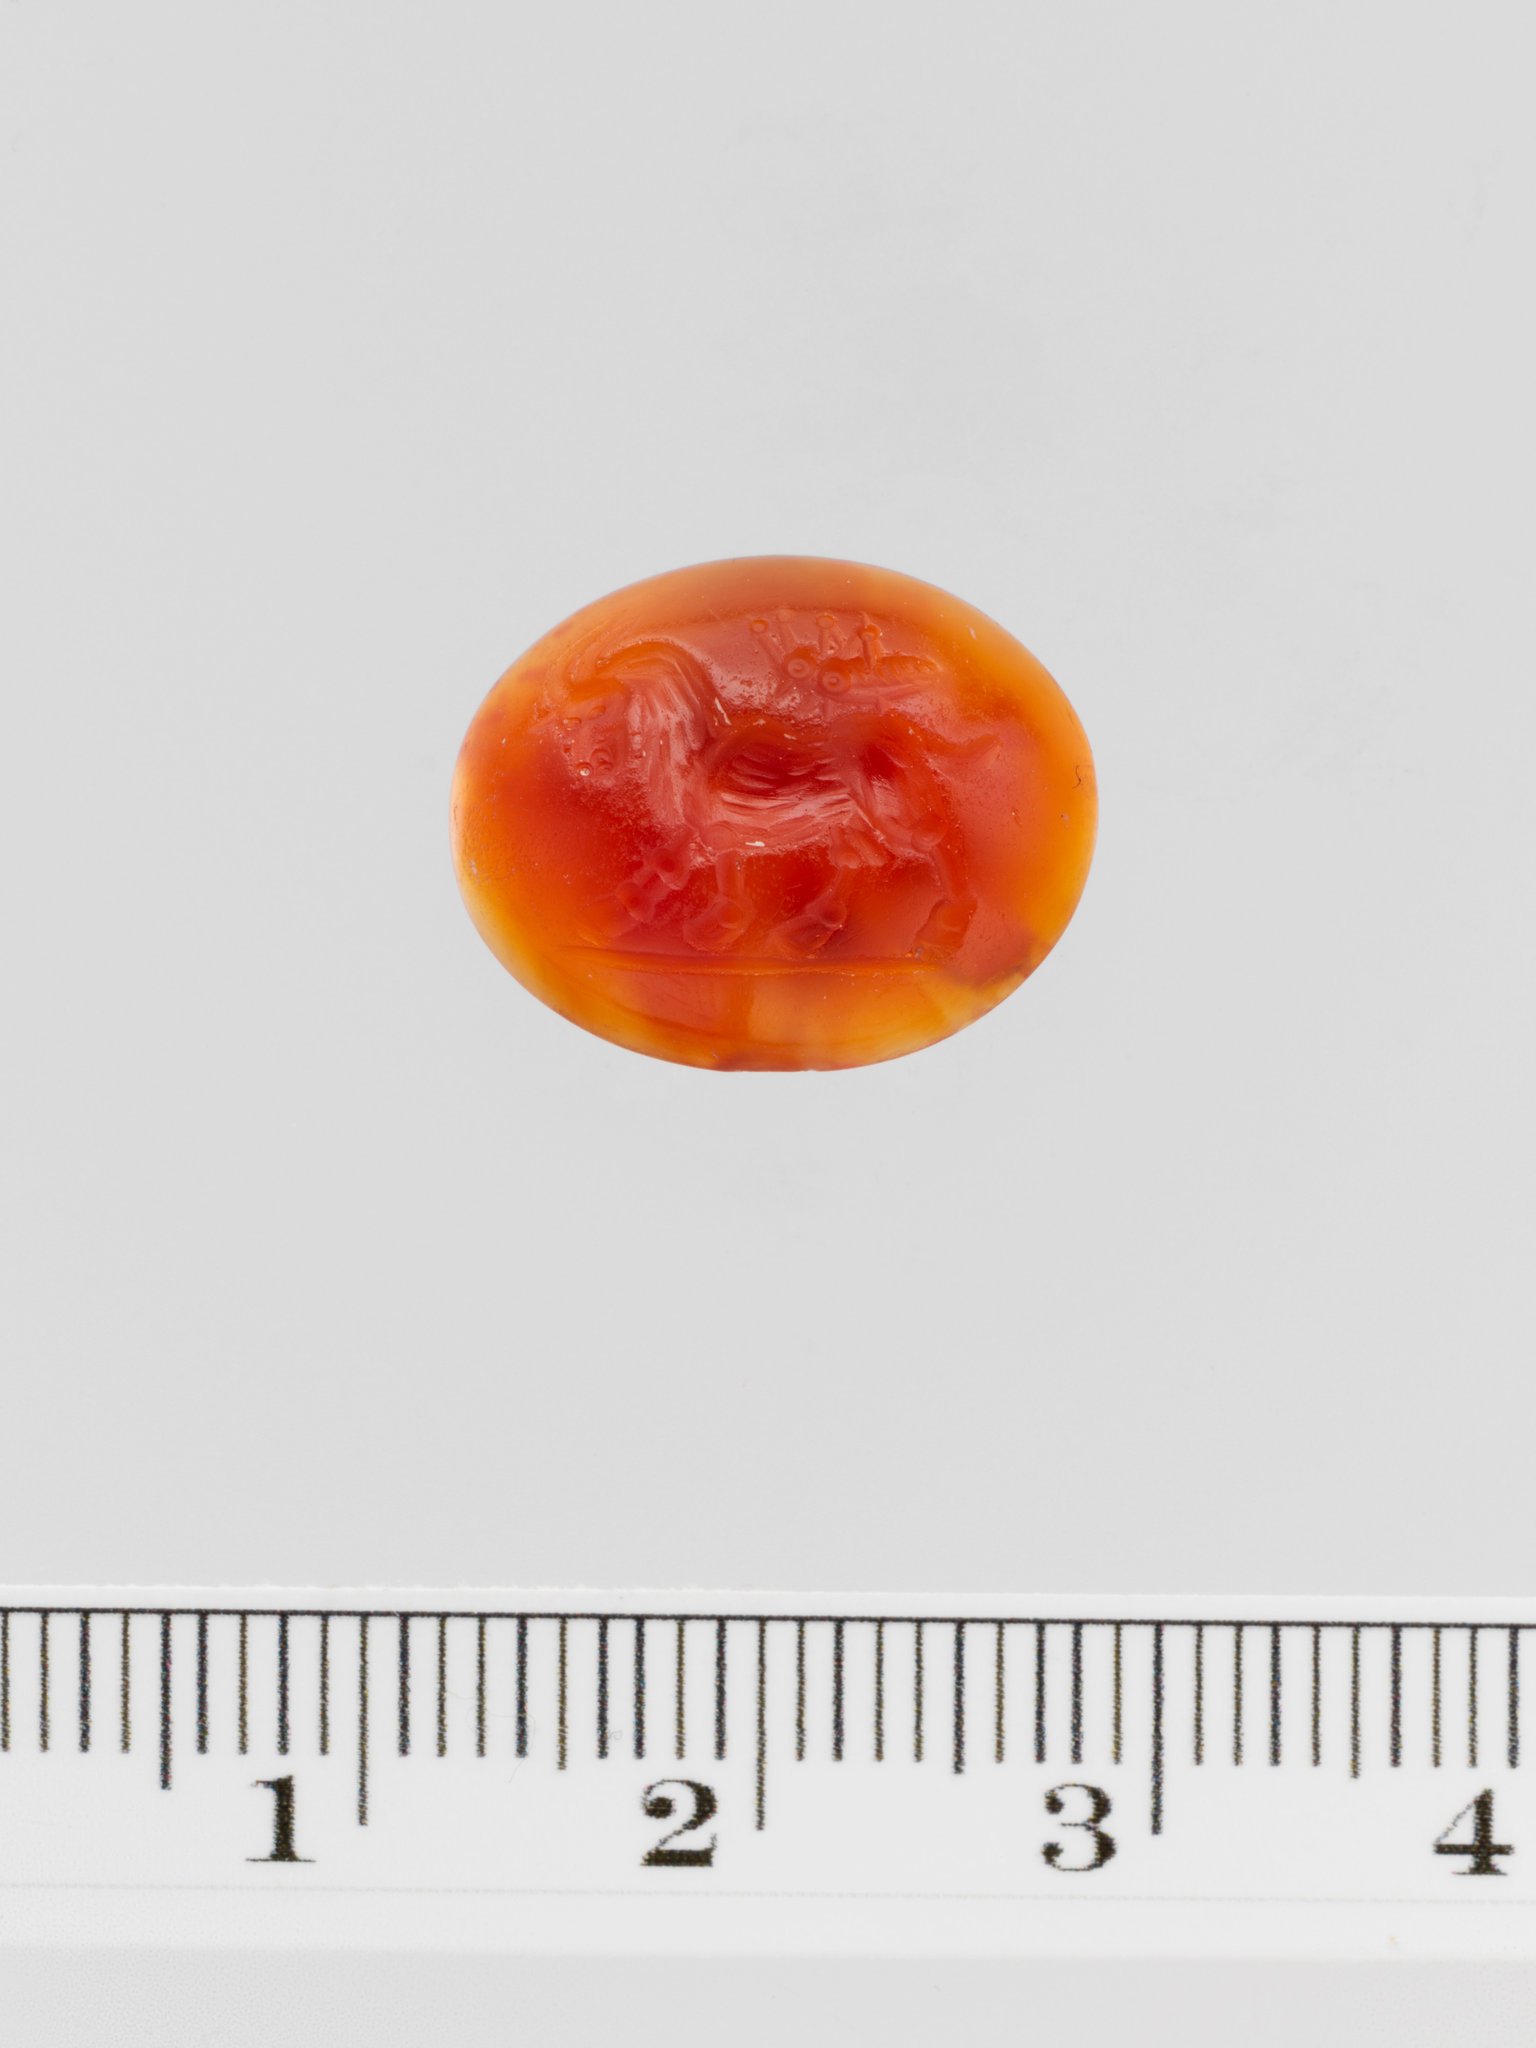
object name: intaglio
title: Carnelian ring stone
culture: italic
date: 300-101 BCE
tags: goats,insects